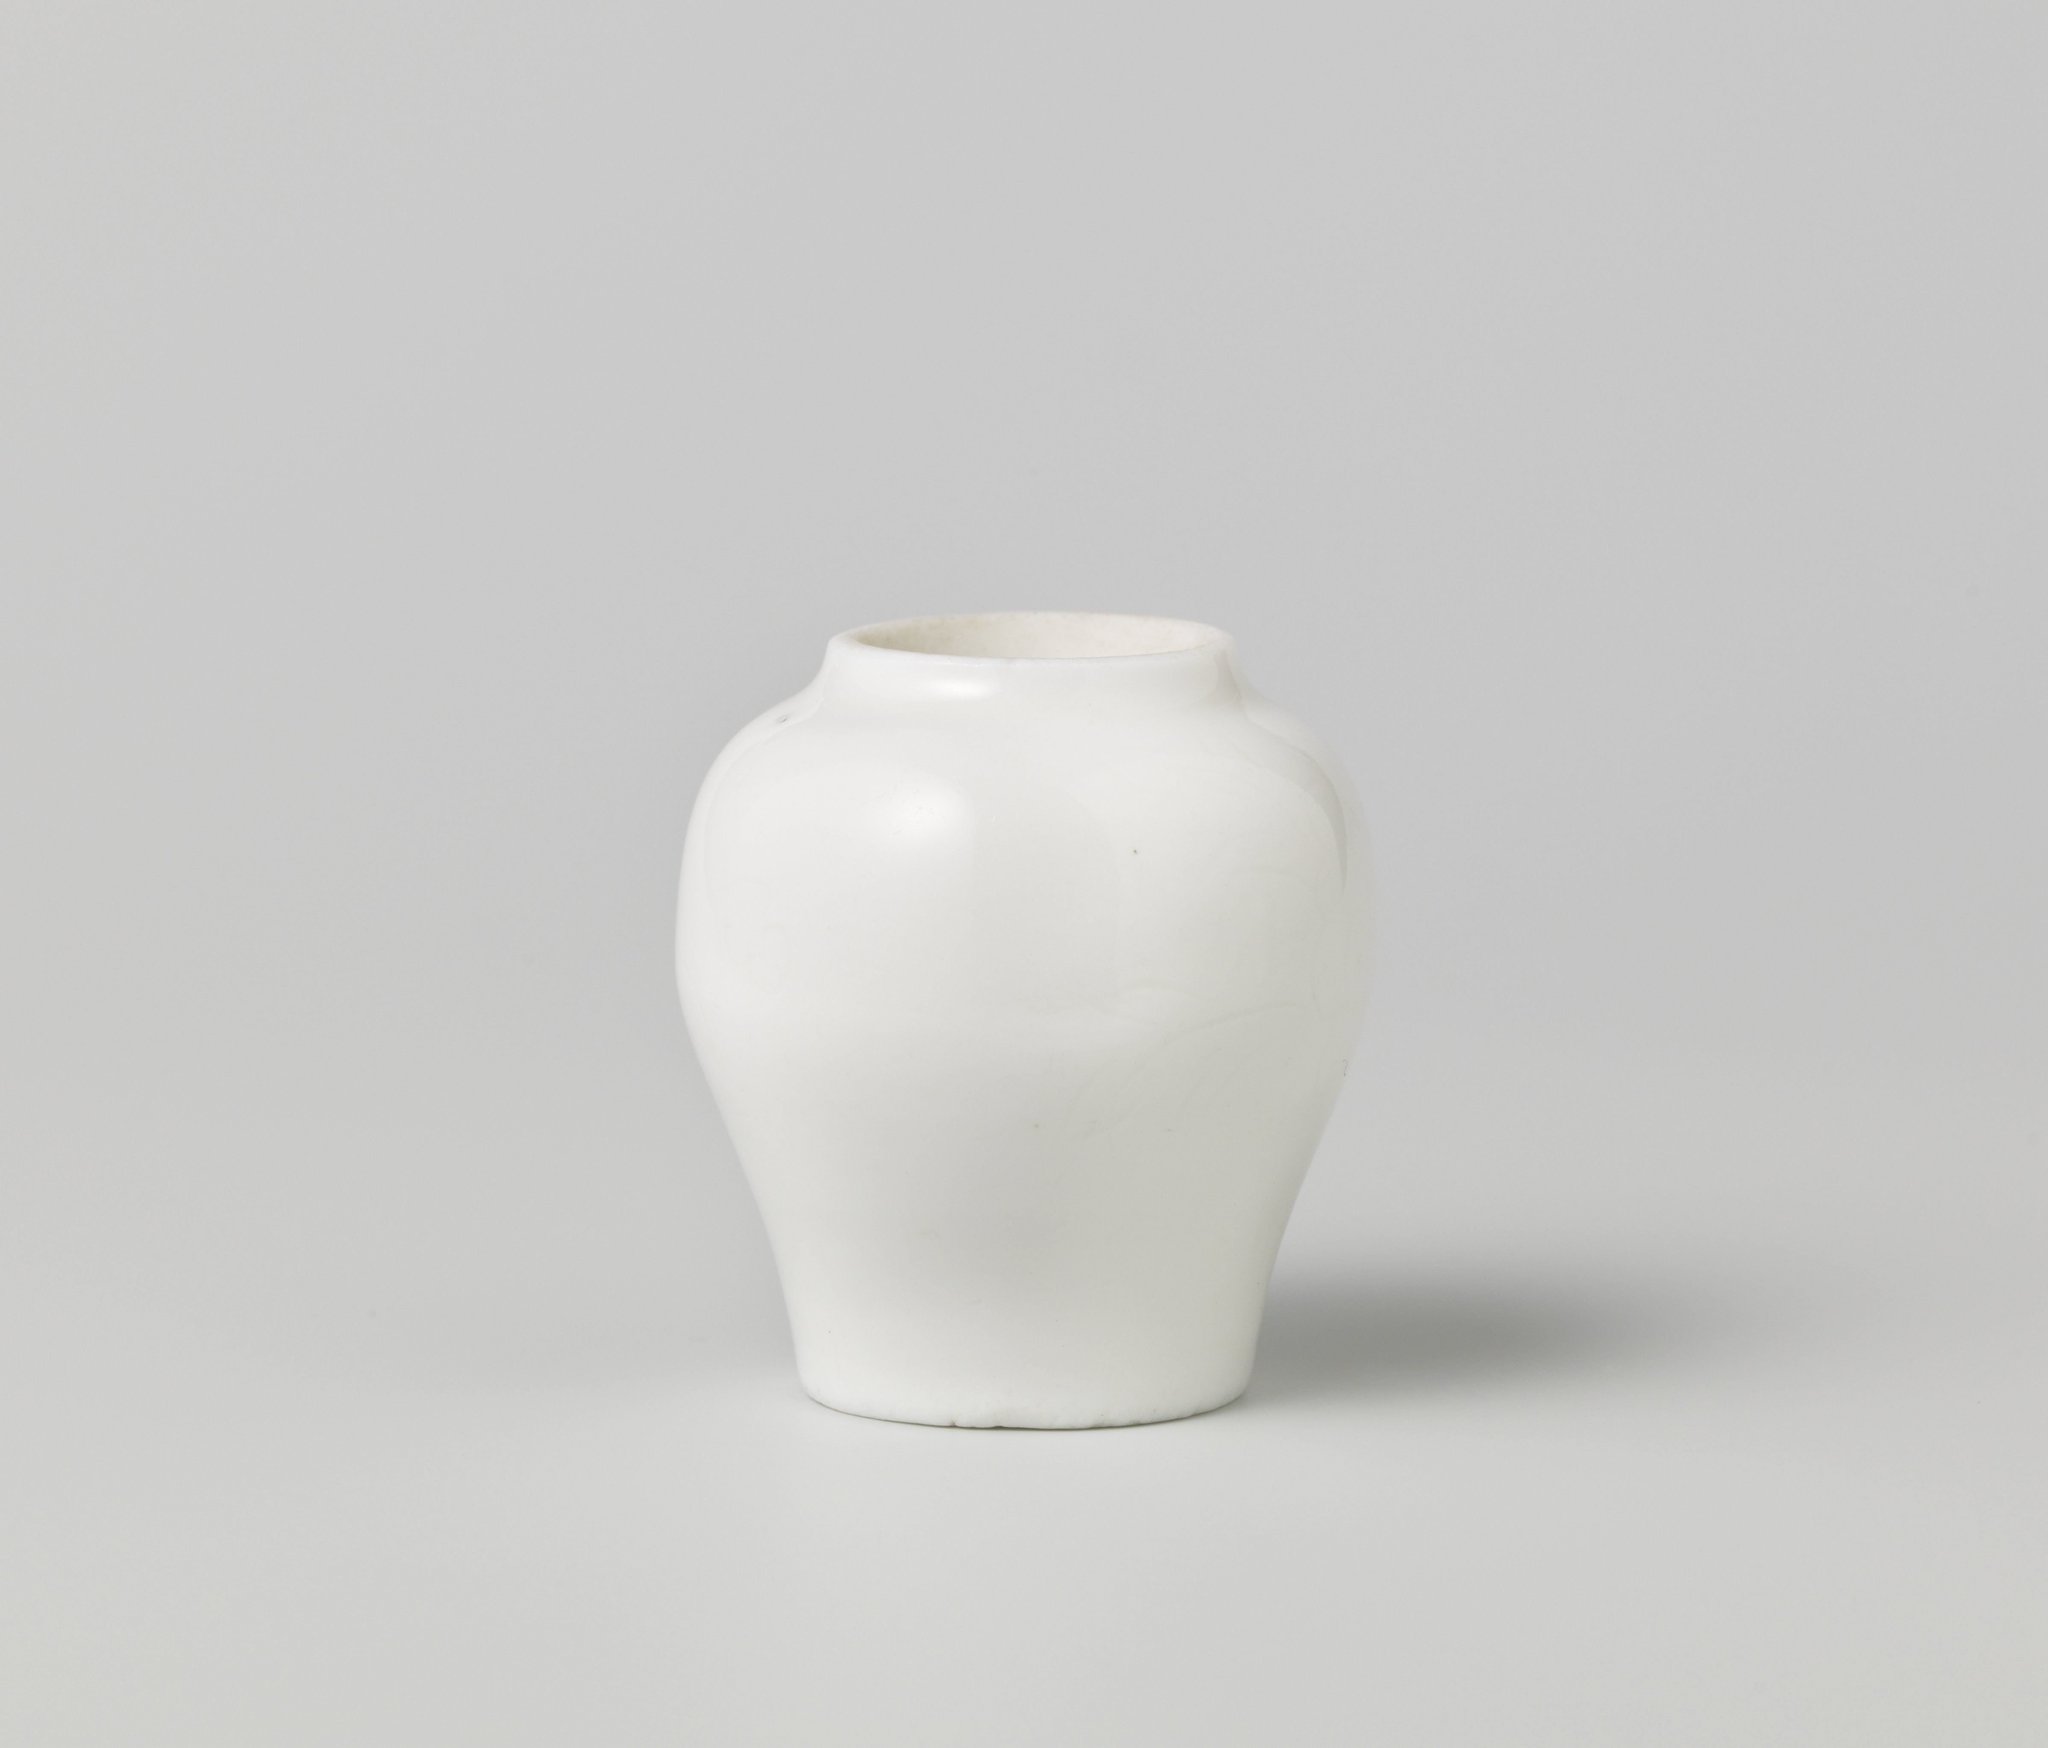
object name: vase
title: Small, baluster vase with lightly incised flower spray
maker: Anonymous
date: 1750-1774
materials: glaze, porcelain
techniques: firing, turning, vitrification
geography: dehua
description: AK-NM-6533 Twee kleine balustervormige vazen • Dehua blanc de China • Onderdeel van Royers studiecollectie (inventaris Van de Kasteele 1816, nr. 287) • Mogelijk afkomstig van Susanna Louisa Huygens Het is opmerkelijk dat in de rubriek ‘Wit Porceleyn Beeldwerk’ in de boedelbeschrijving van Royers oudtante Susanna Louisa Huygens (1714-1785) blijkbaar ook vaatwerk voorkwam. We treffen daar ‘Twee tonnetjes en een kannetje dito [met bloemen, opwerk] met oiren’. Mogelijk zijn Royers vaasjes de twee tonnetjes uit deze beschrijving, al zijn de bloemtakken ingegrift en geen ‘opwerk’, reliëf. Royer nam veel porselein over uit de nalatenschap van zijn oudtante, maar er is helaas niet precies vastgelegd welke stukken.